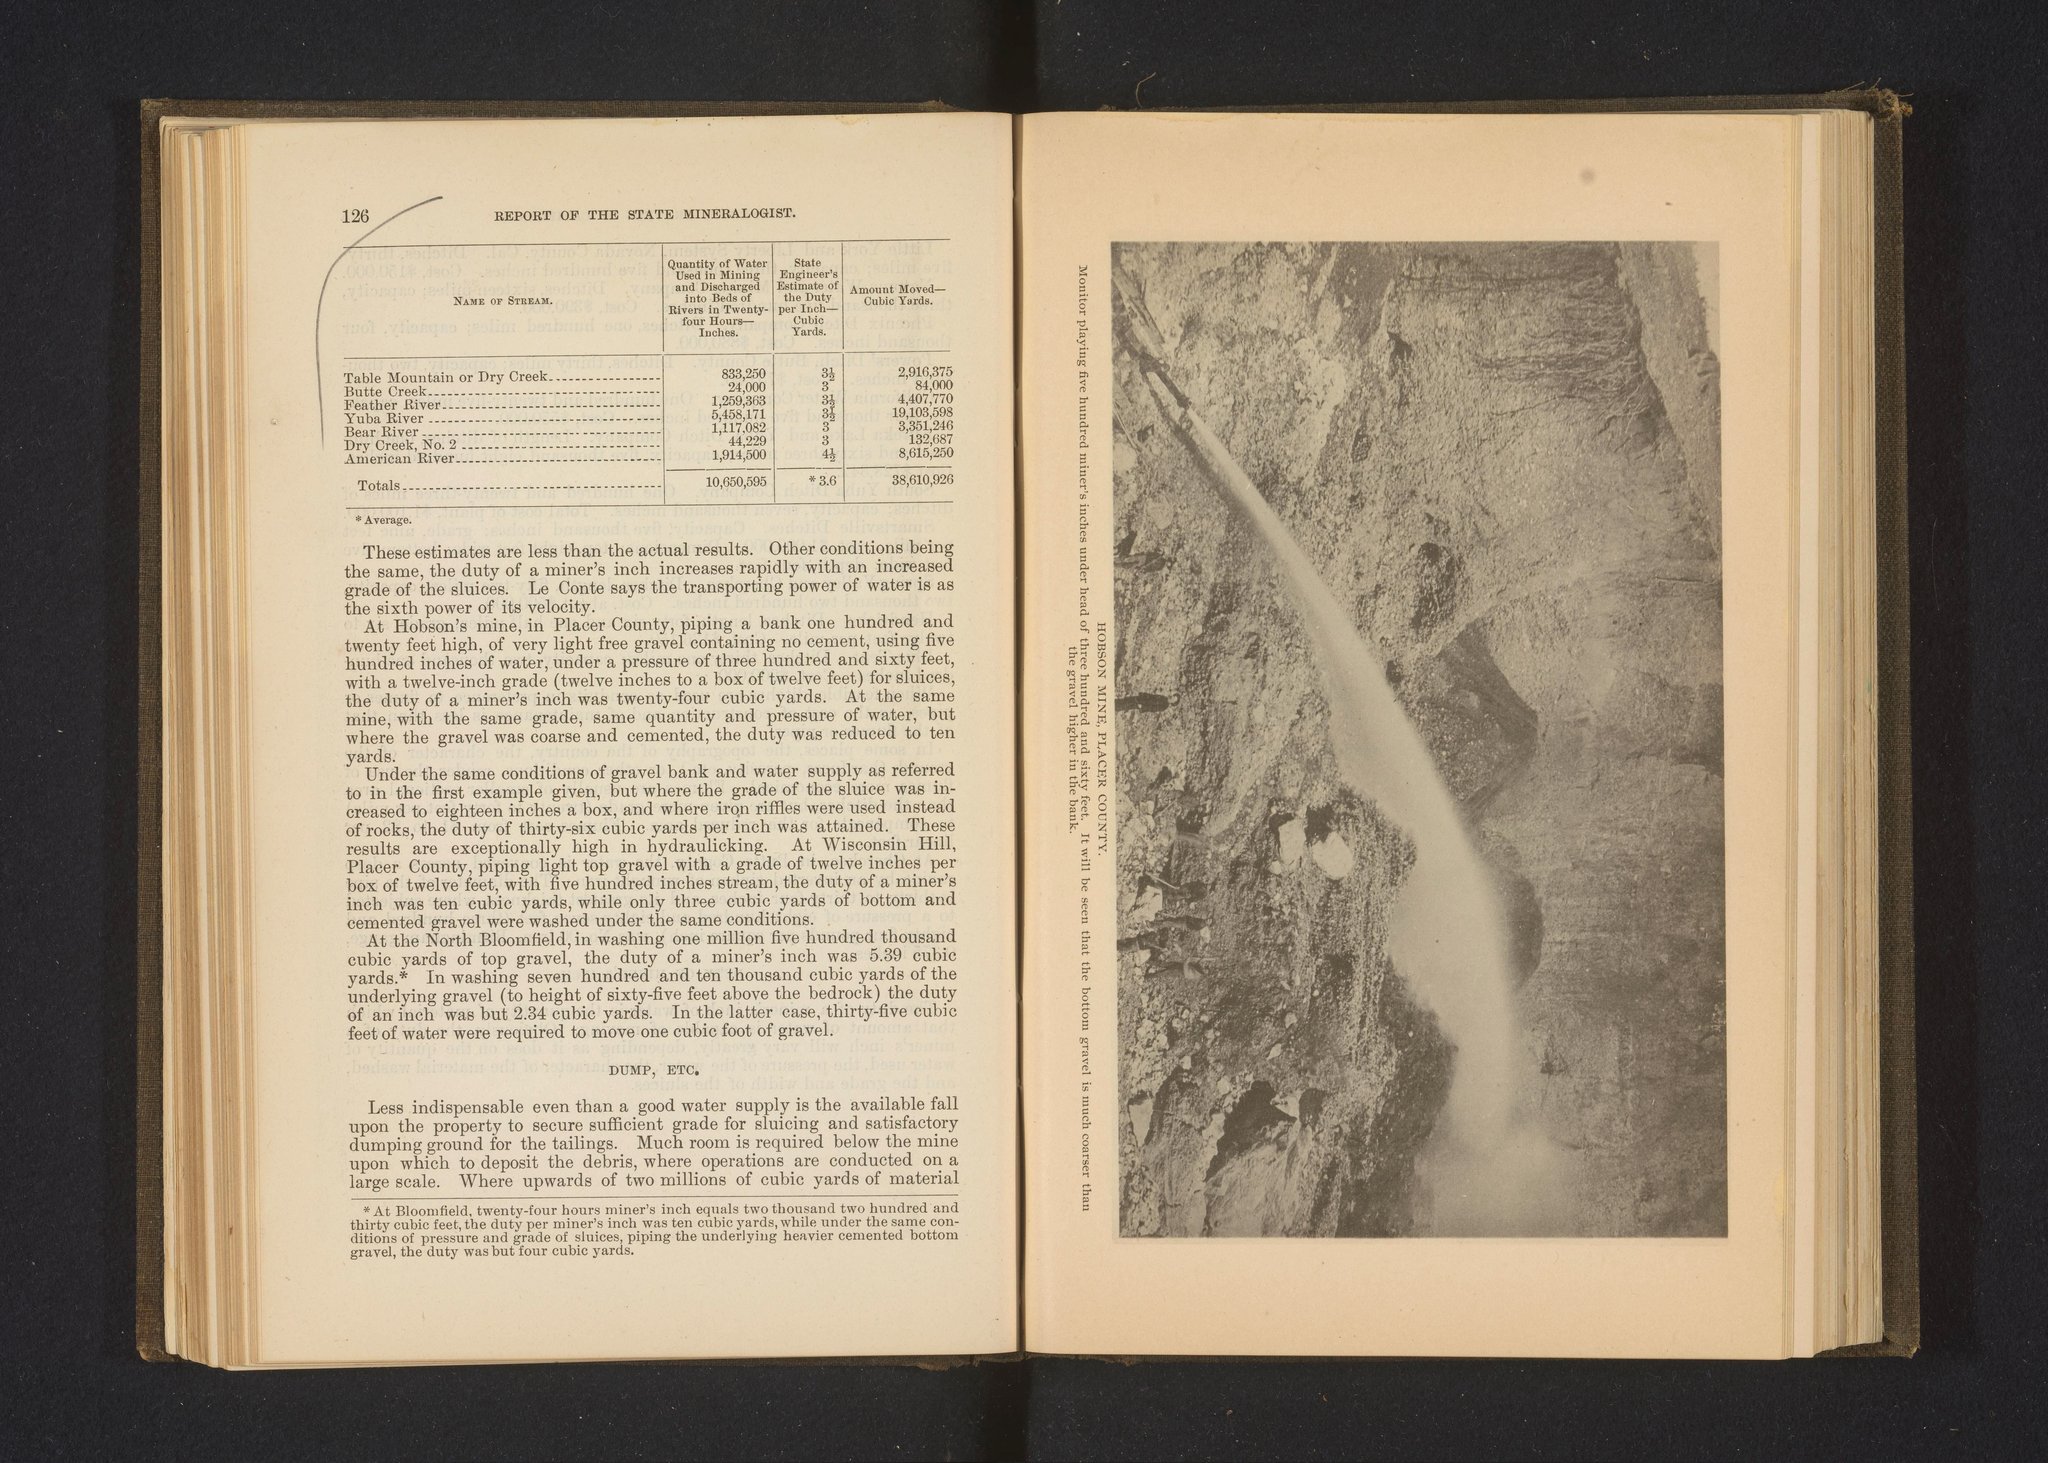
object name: photomechanical print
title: Hobson Mine, Placer County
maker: Anonymous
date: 1885-1890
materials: paper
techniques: photograph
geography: placer county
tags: mine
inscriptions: inscription: ‘Monitor playing five hundred miner's inches under head of three hundred and sixty feet. It will be seen that the bottom gravel is much coarser than/ the gravel higher in the bank.’